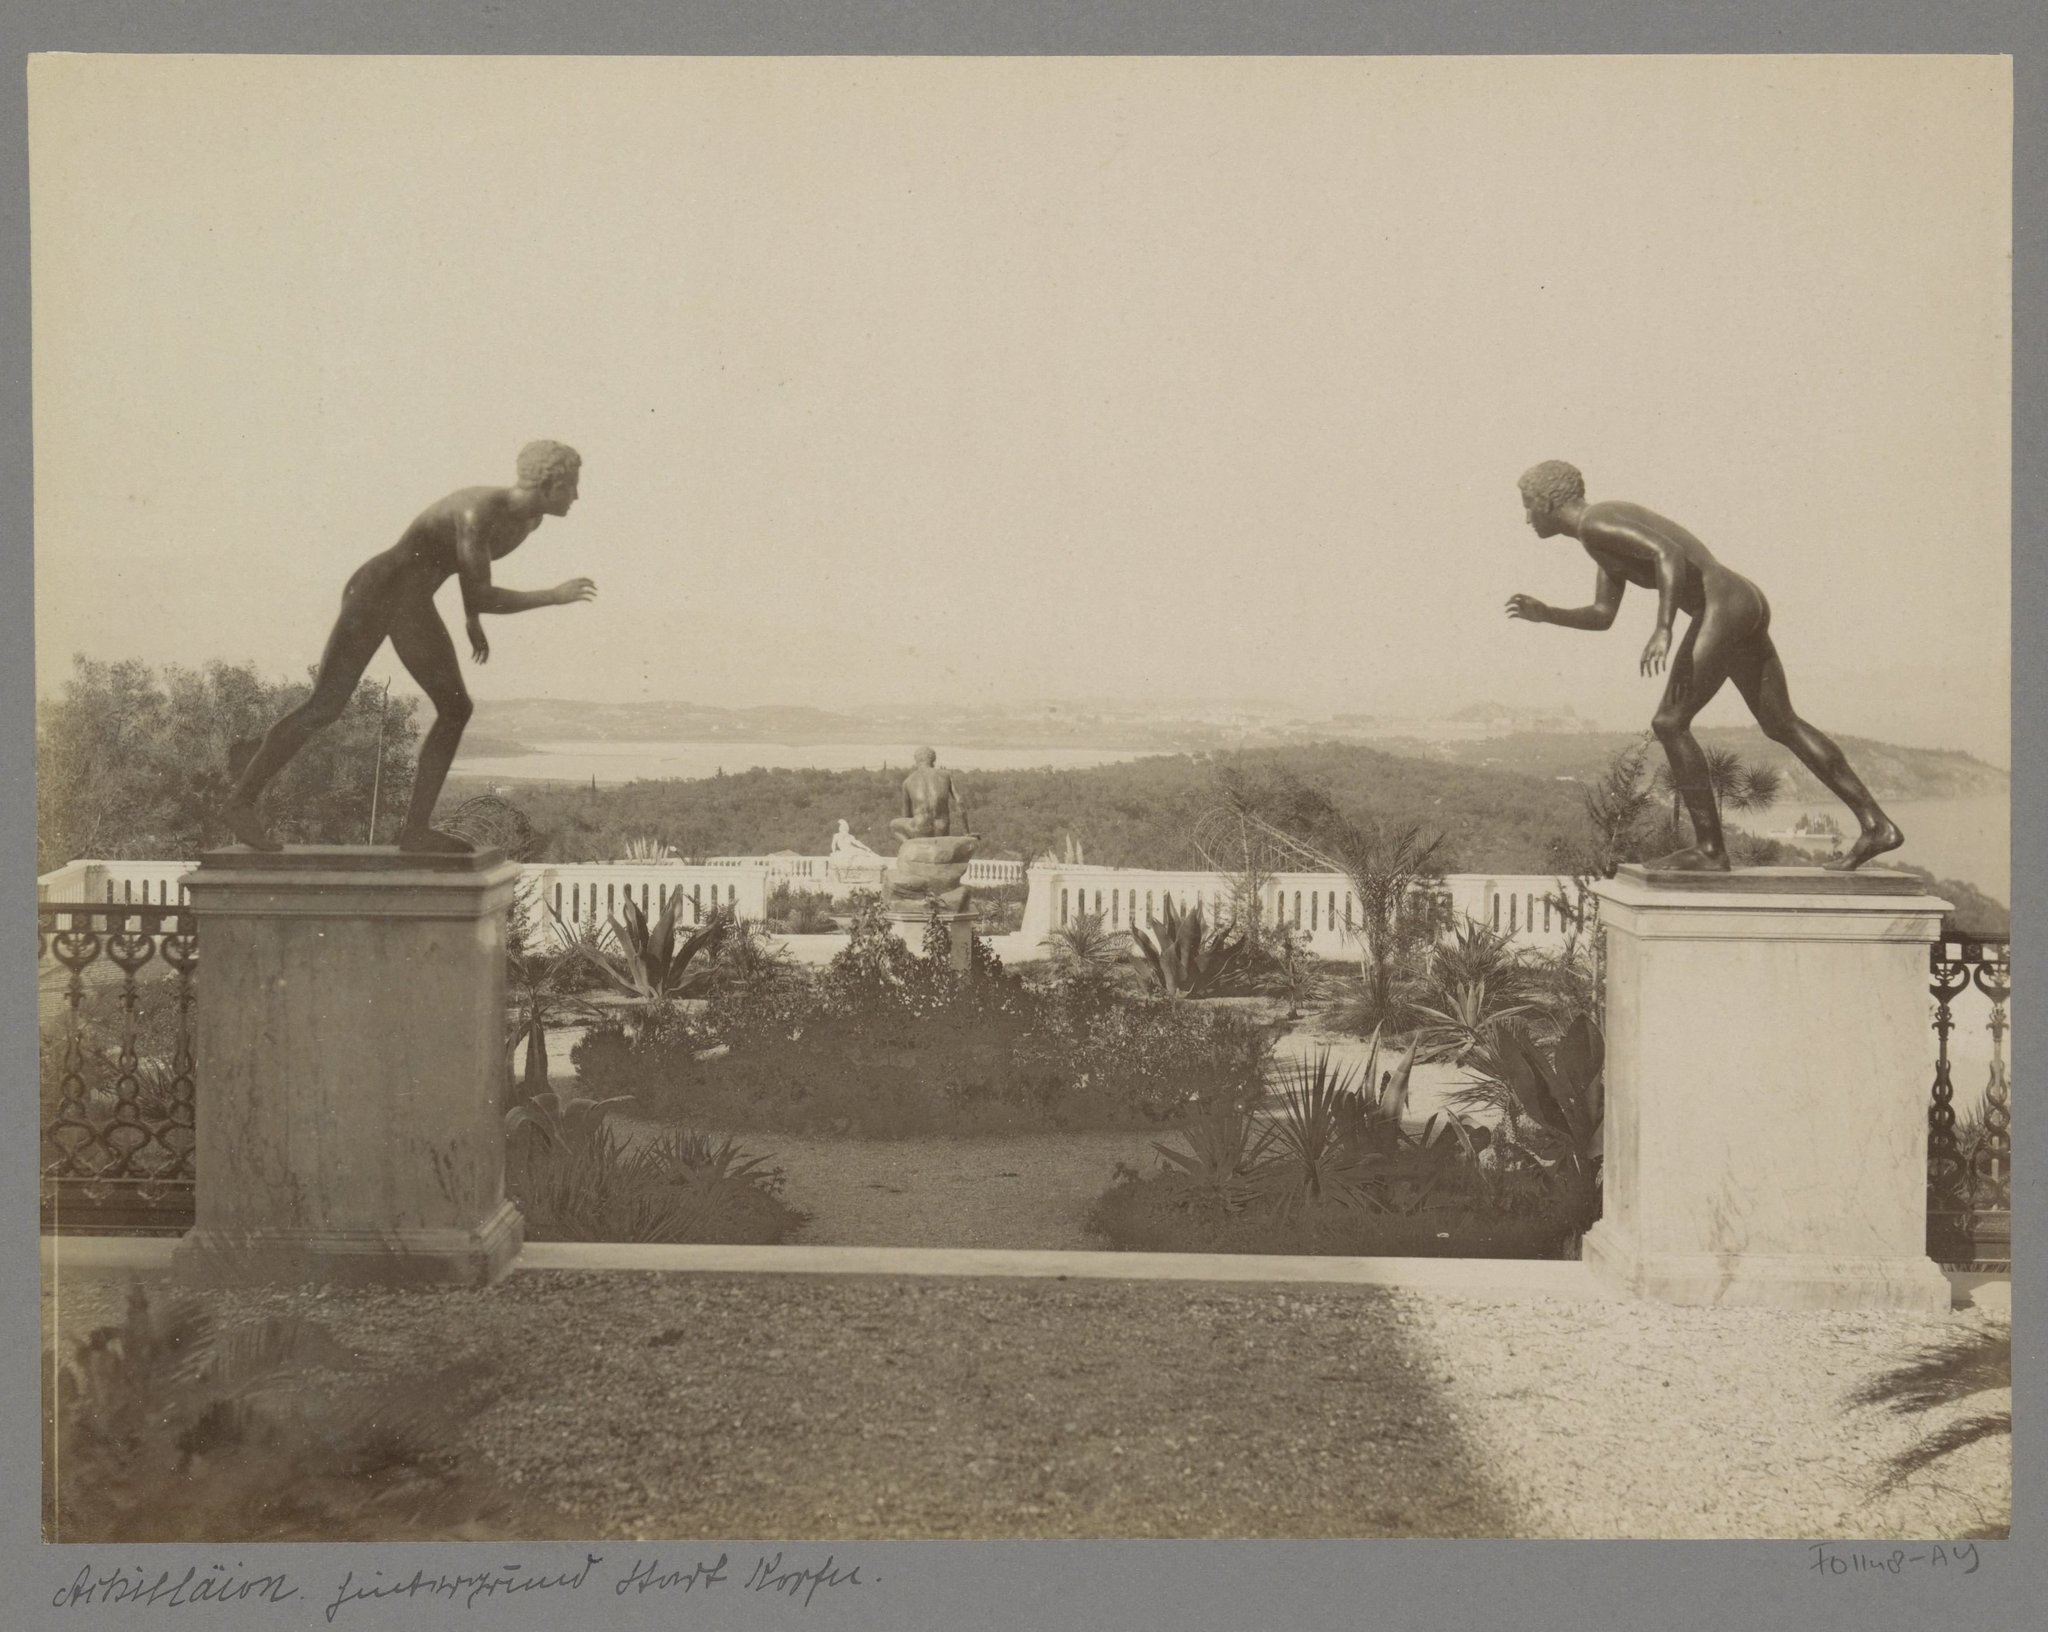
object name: photograph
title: Beelden in de tuin van het Achilleion op Corfu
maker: Anonymous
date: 1895-1905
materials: paper, photographic support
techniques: albumen print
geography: corfu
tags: garden, piece of sculpture, reproduction of a piece of sculpture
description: Onderdeel van Reisalbum met foto's van bezienswaardigheden in Griekenland en Egypte.